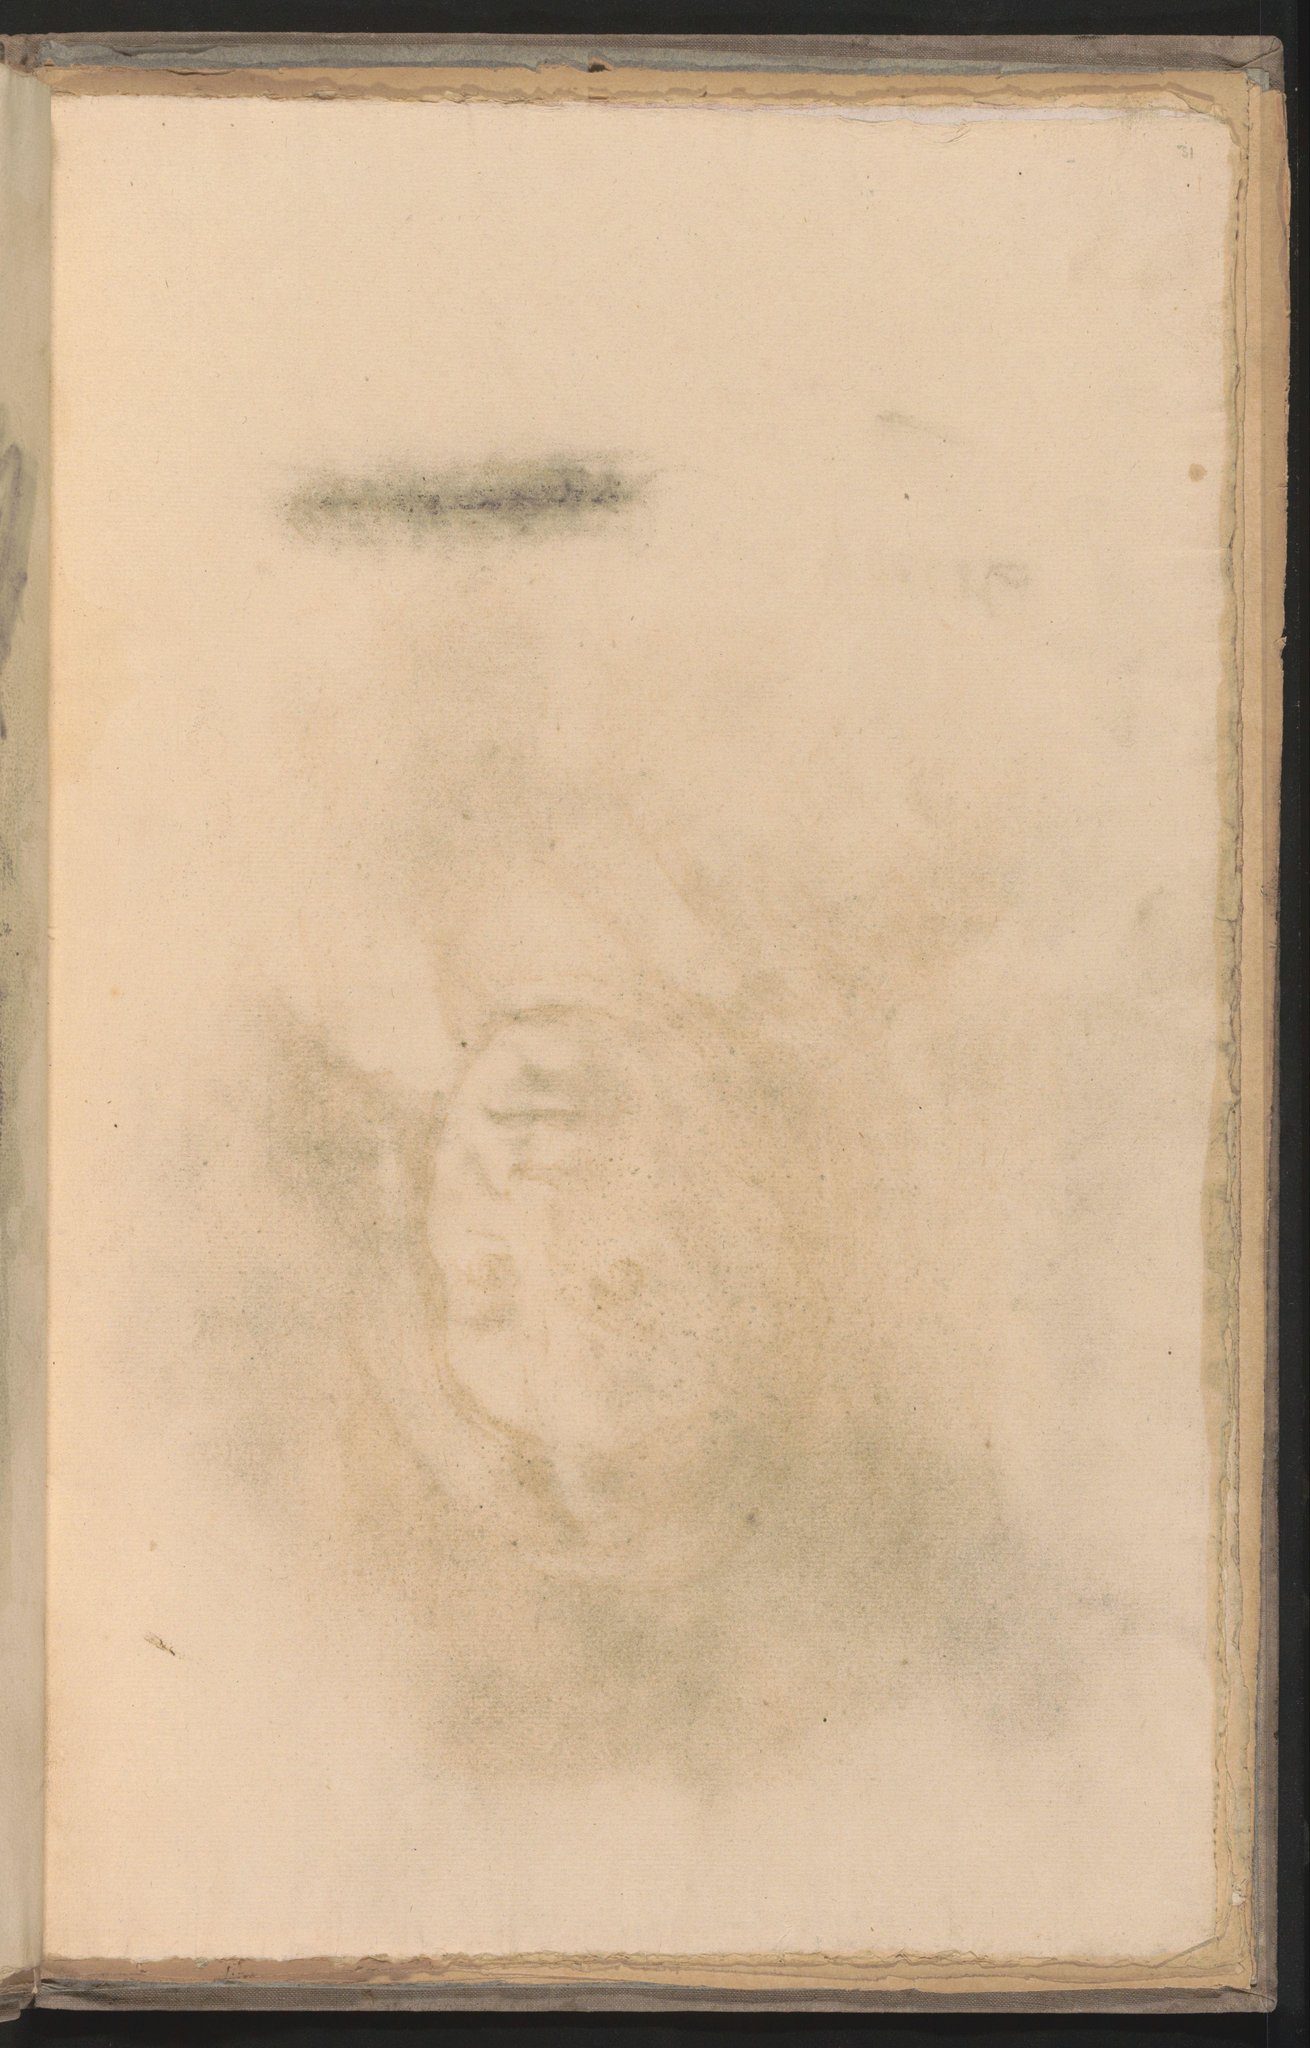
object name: sketchbook leaf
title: Abklatsch van de krijttekening op pagina 30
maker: willem witsen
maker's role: draughtsman, painter, print maker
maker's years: 1860-1923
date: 1886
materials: paper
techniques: printmaking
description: Pagina 31 uit een schetsboek met 38 bladen betekend rond de Ewijkshoeve.